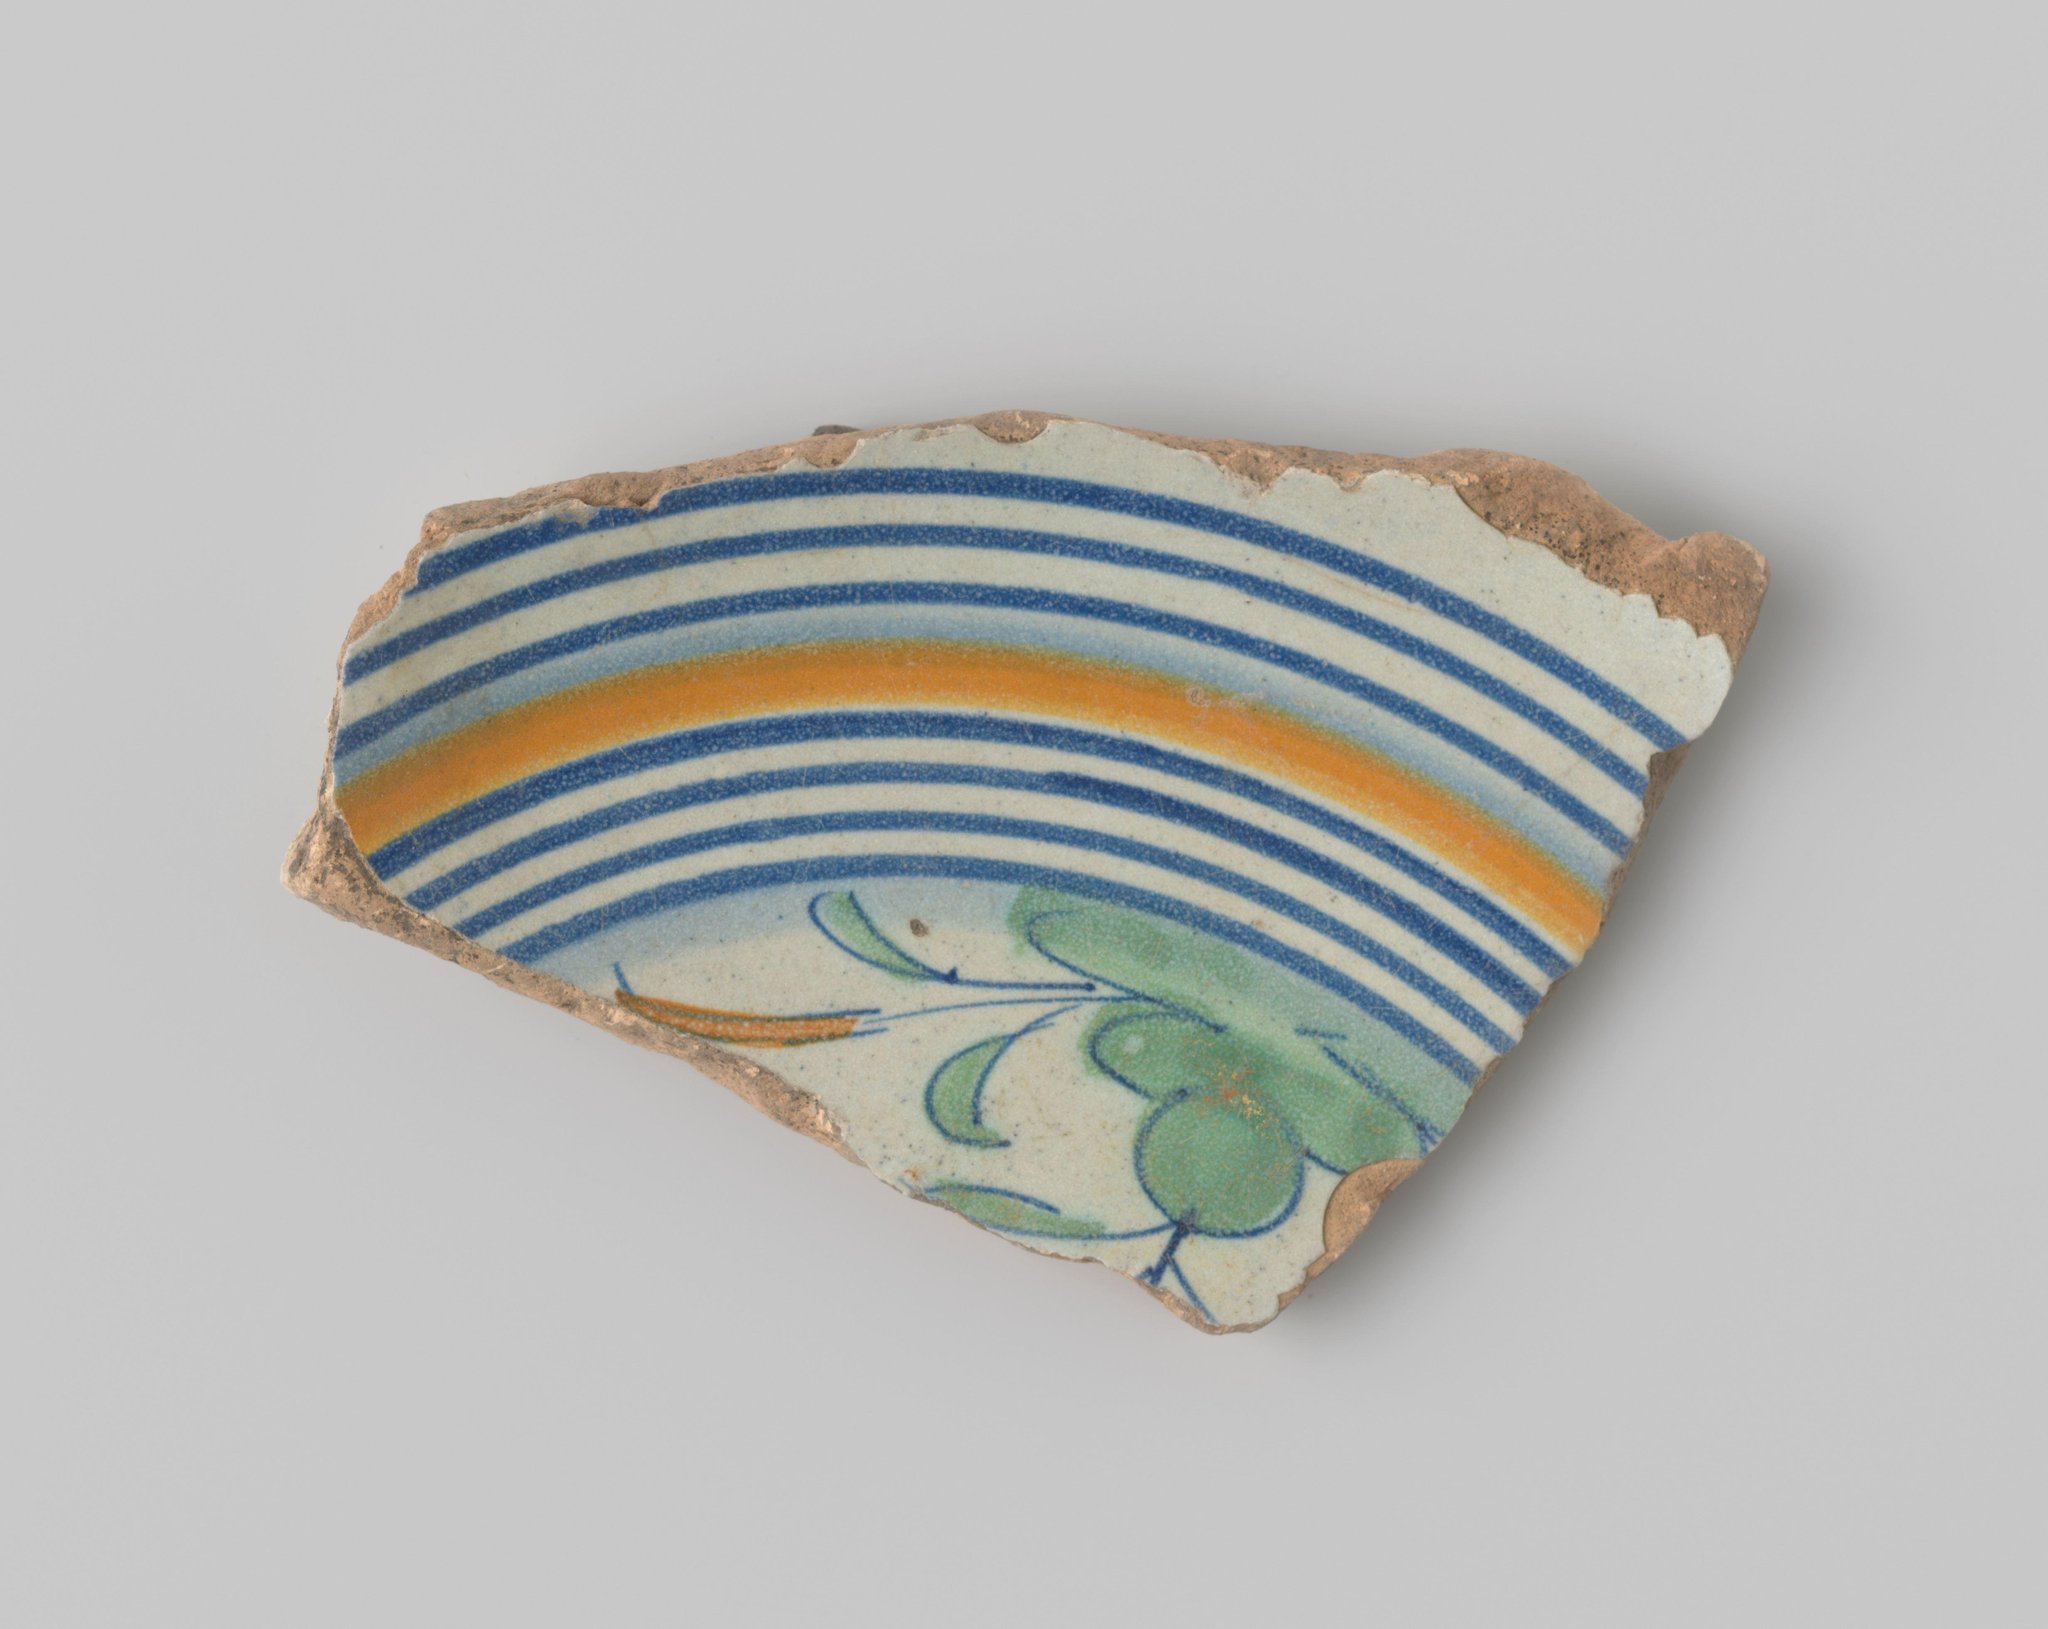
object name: sherd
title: Scherf van roodbakkend aardewerk,aan de bovenzijde voorzien van een beschildering van strepen in blauw en oranje, en een struik in groen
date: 1500-1899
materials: earthenware, glaze